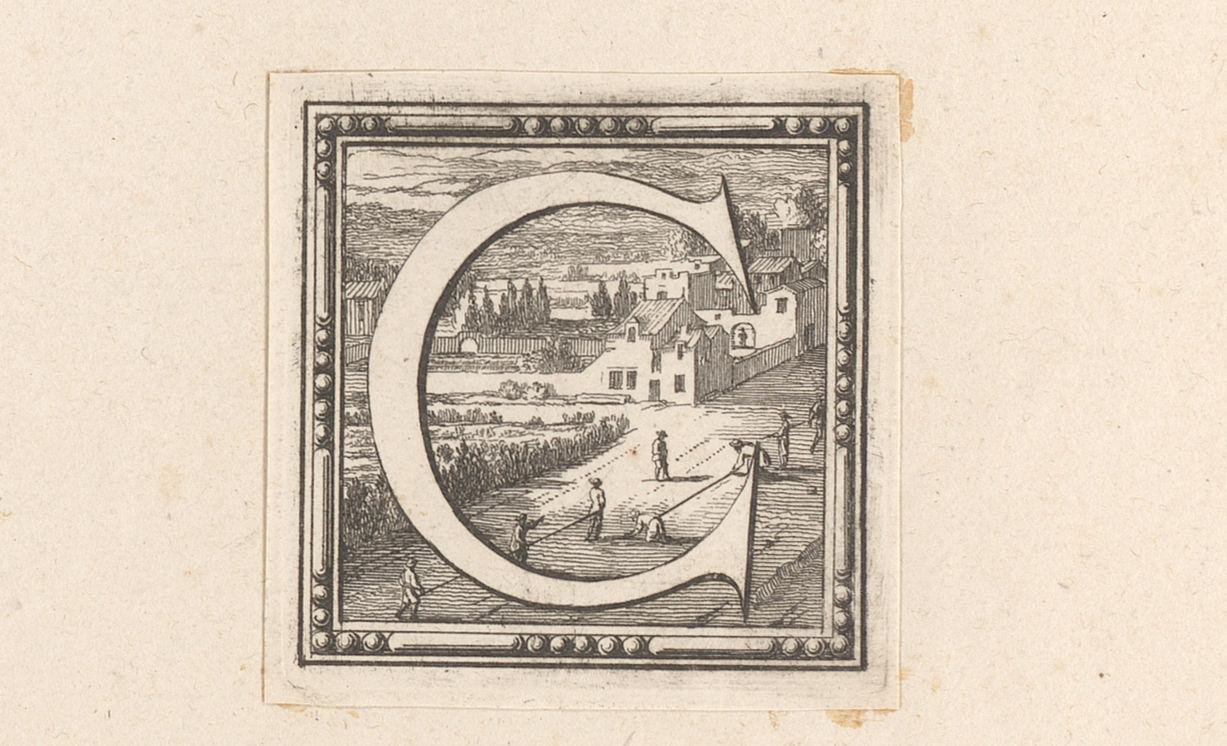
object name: book illustration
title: Initiaal 'C' met landmeters een weg opmetend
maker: sébastien leclerc (i)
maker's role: print maker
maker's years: 1637-1714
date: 1671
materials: paper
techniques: etching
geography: paris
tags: geodesy, surveying, initial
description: Prent uit: Picard, Abbé Jean. Mesure de la terre. Parijs: Imprimerie Royale, 1671.